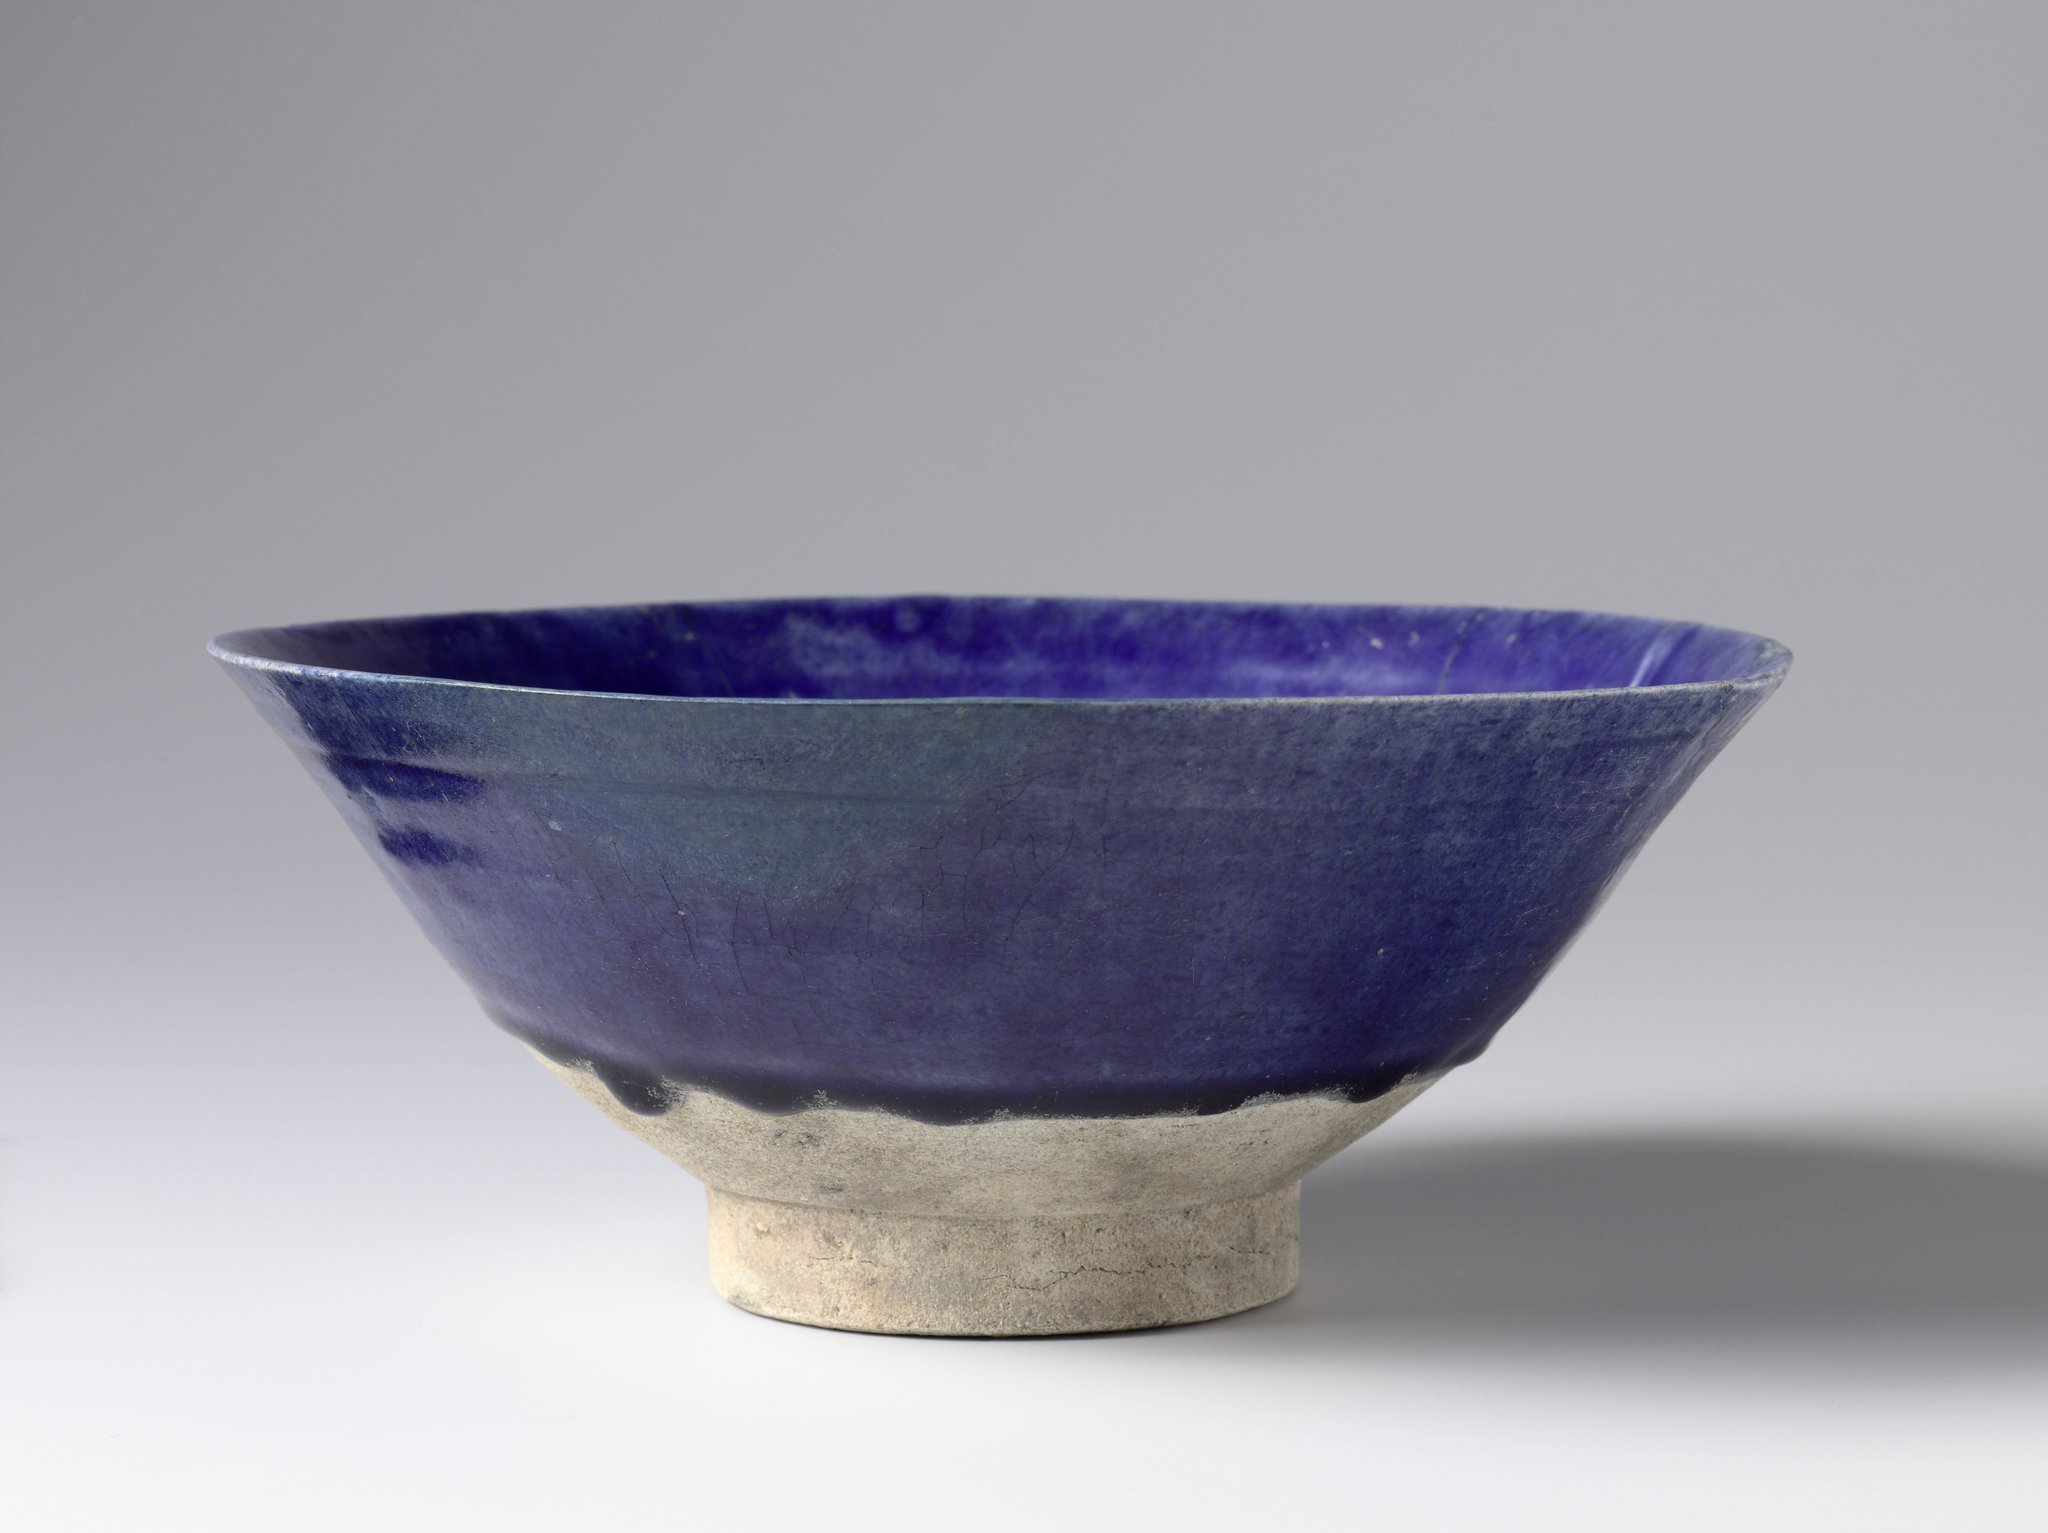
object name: bowl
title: Bowl with a incised scroll border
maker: Anonymous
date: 1175-1224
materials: earthenware, glaze, quartz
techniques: engraving, firing, turning, vitrification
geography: iran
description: Kom van kwarts-fritgoed, gedecoreerd met een band met ingegrifte ranken en krulvormen en bedekt met een monochroom blauw alkaliglazuur.